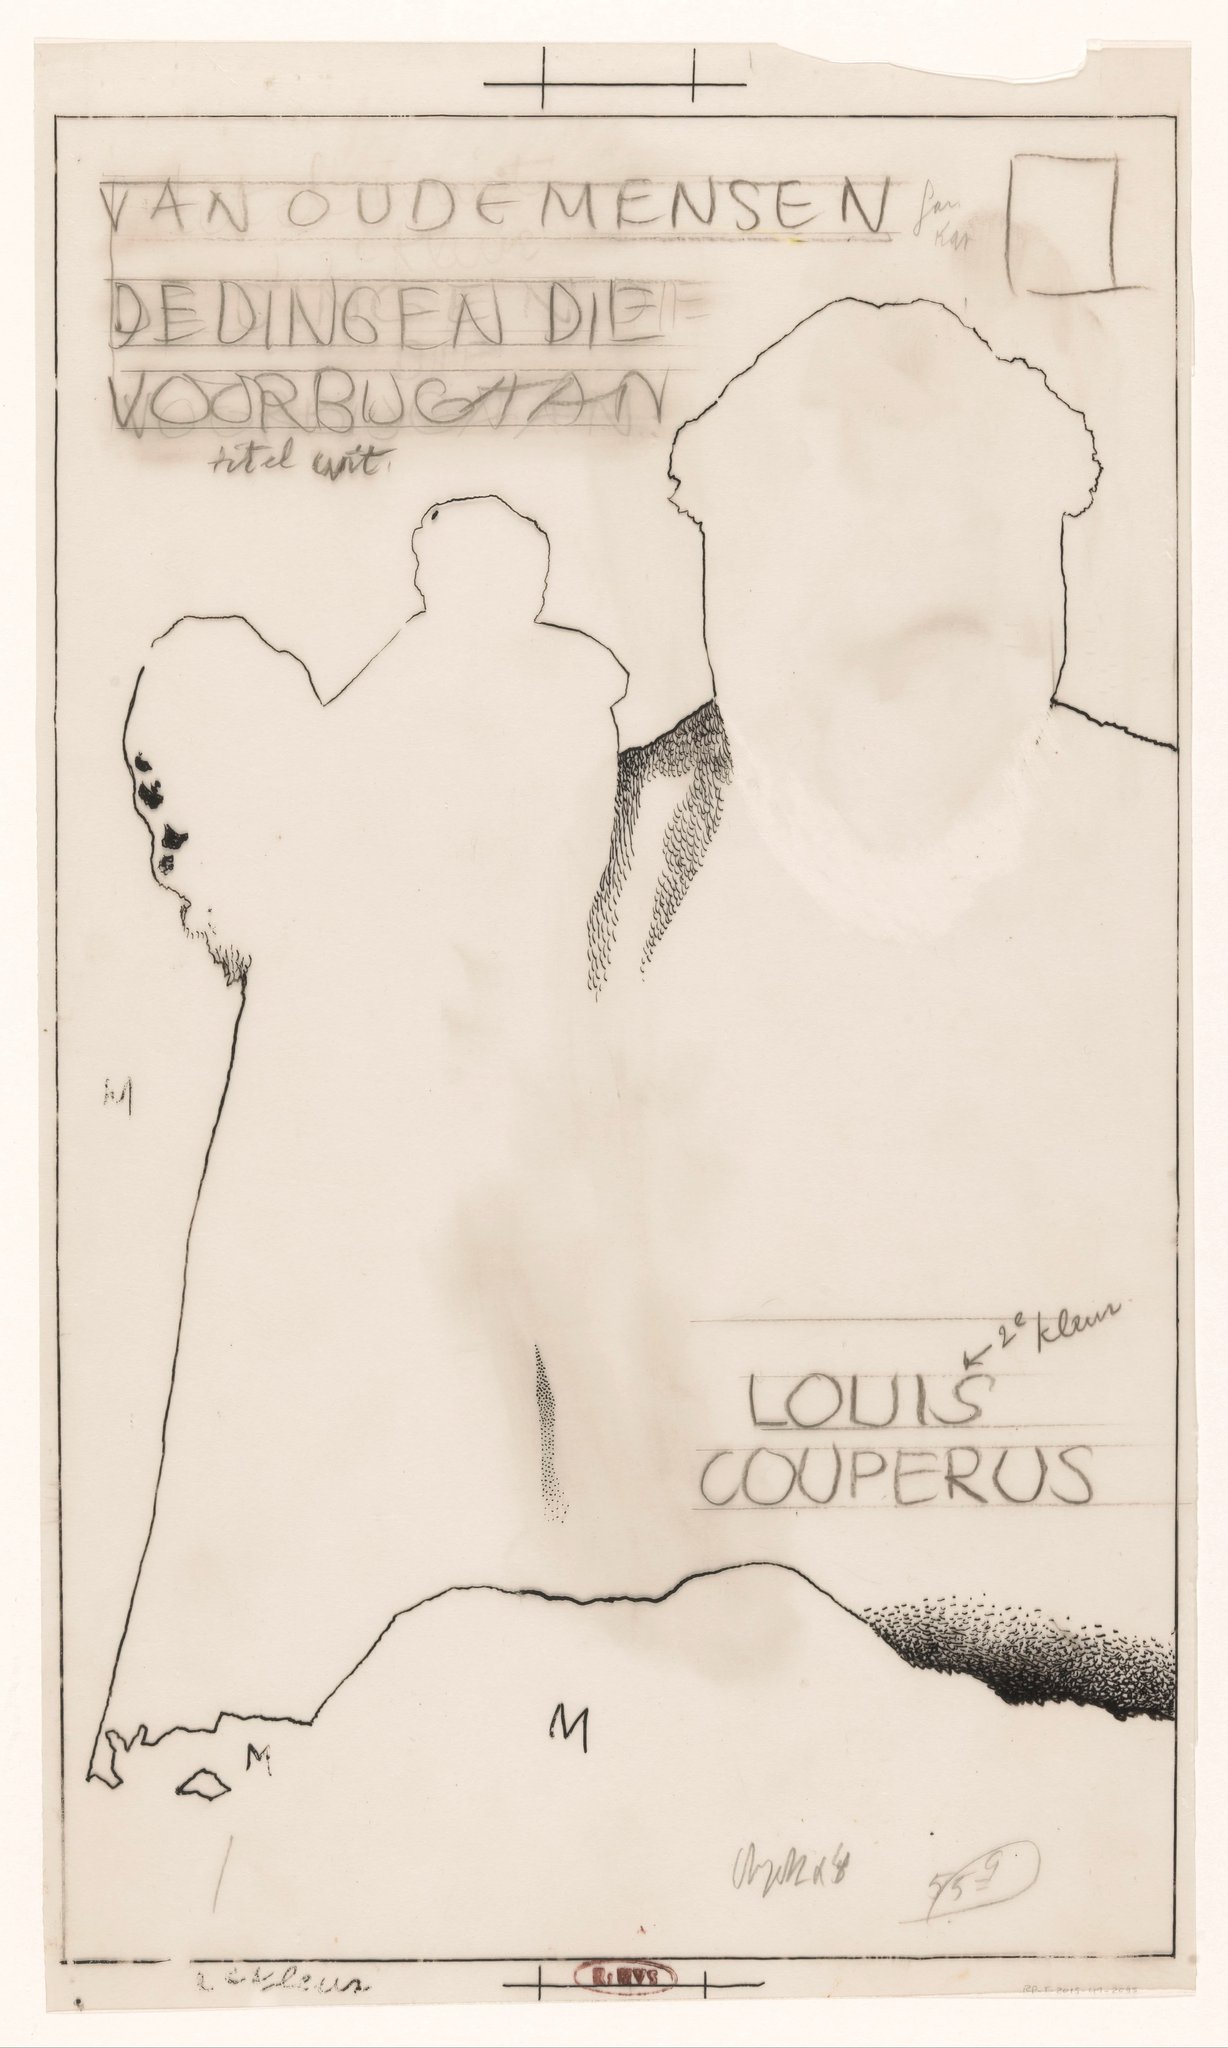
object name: drawing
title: Bandontwerp voor: Louis Couperus, Van oude menschen, de dingen die voorbijgaan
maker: Anonymous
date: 1906-1970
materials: ink, paper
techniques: pen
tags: head (human), (lovers) embracing each other, 'symplegma'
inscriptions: :, collector's mark: Lugt 2228a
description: Boektitel en auteursnaam met het silhouet van een staande man en vrouw, mogelijk elkaar omhelzend, en de omtrek van het hoofd van een man.